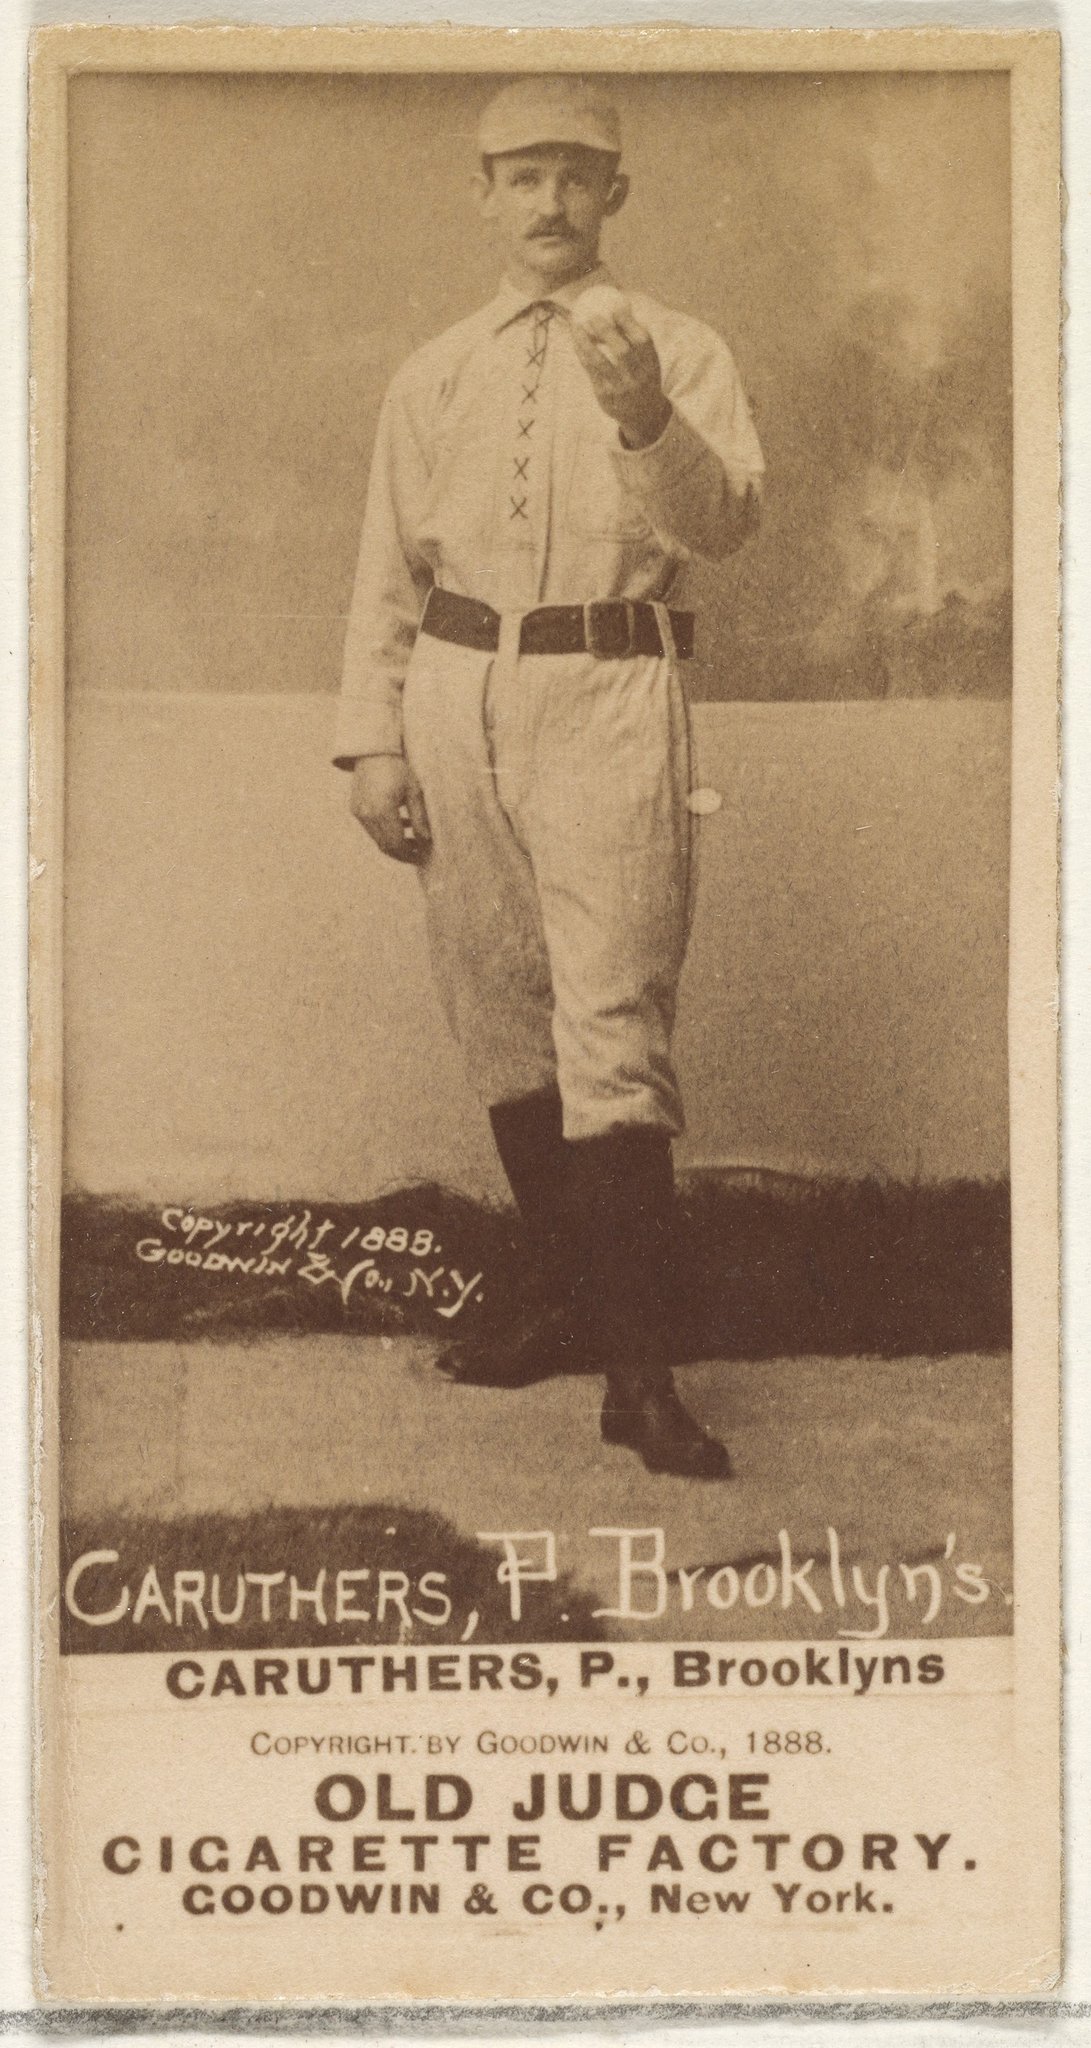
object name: baseball card, photograph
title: Caruthers, Pitcher, Brooklyn, from the Old Judge series (N172) for Old Judge Cigarettes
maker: goodwin & company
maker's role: publisher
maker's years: 1850-1950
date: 1888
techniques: albumen silver print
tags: men,portraits,baseball,athletes